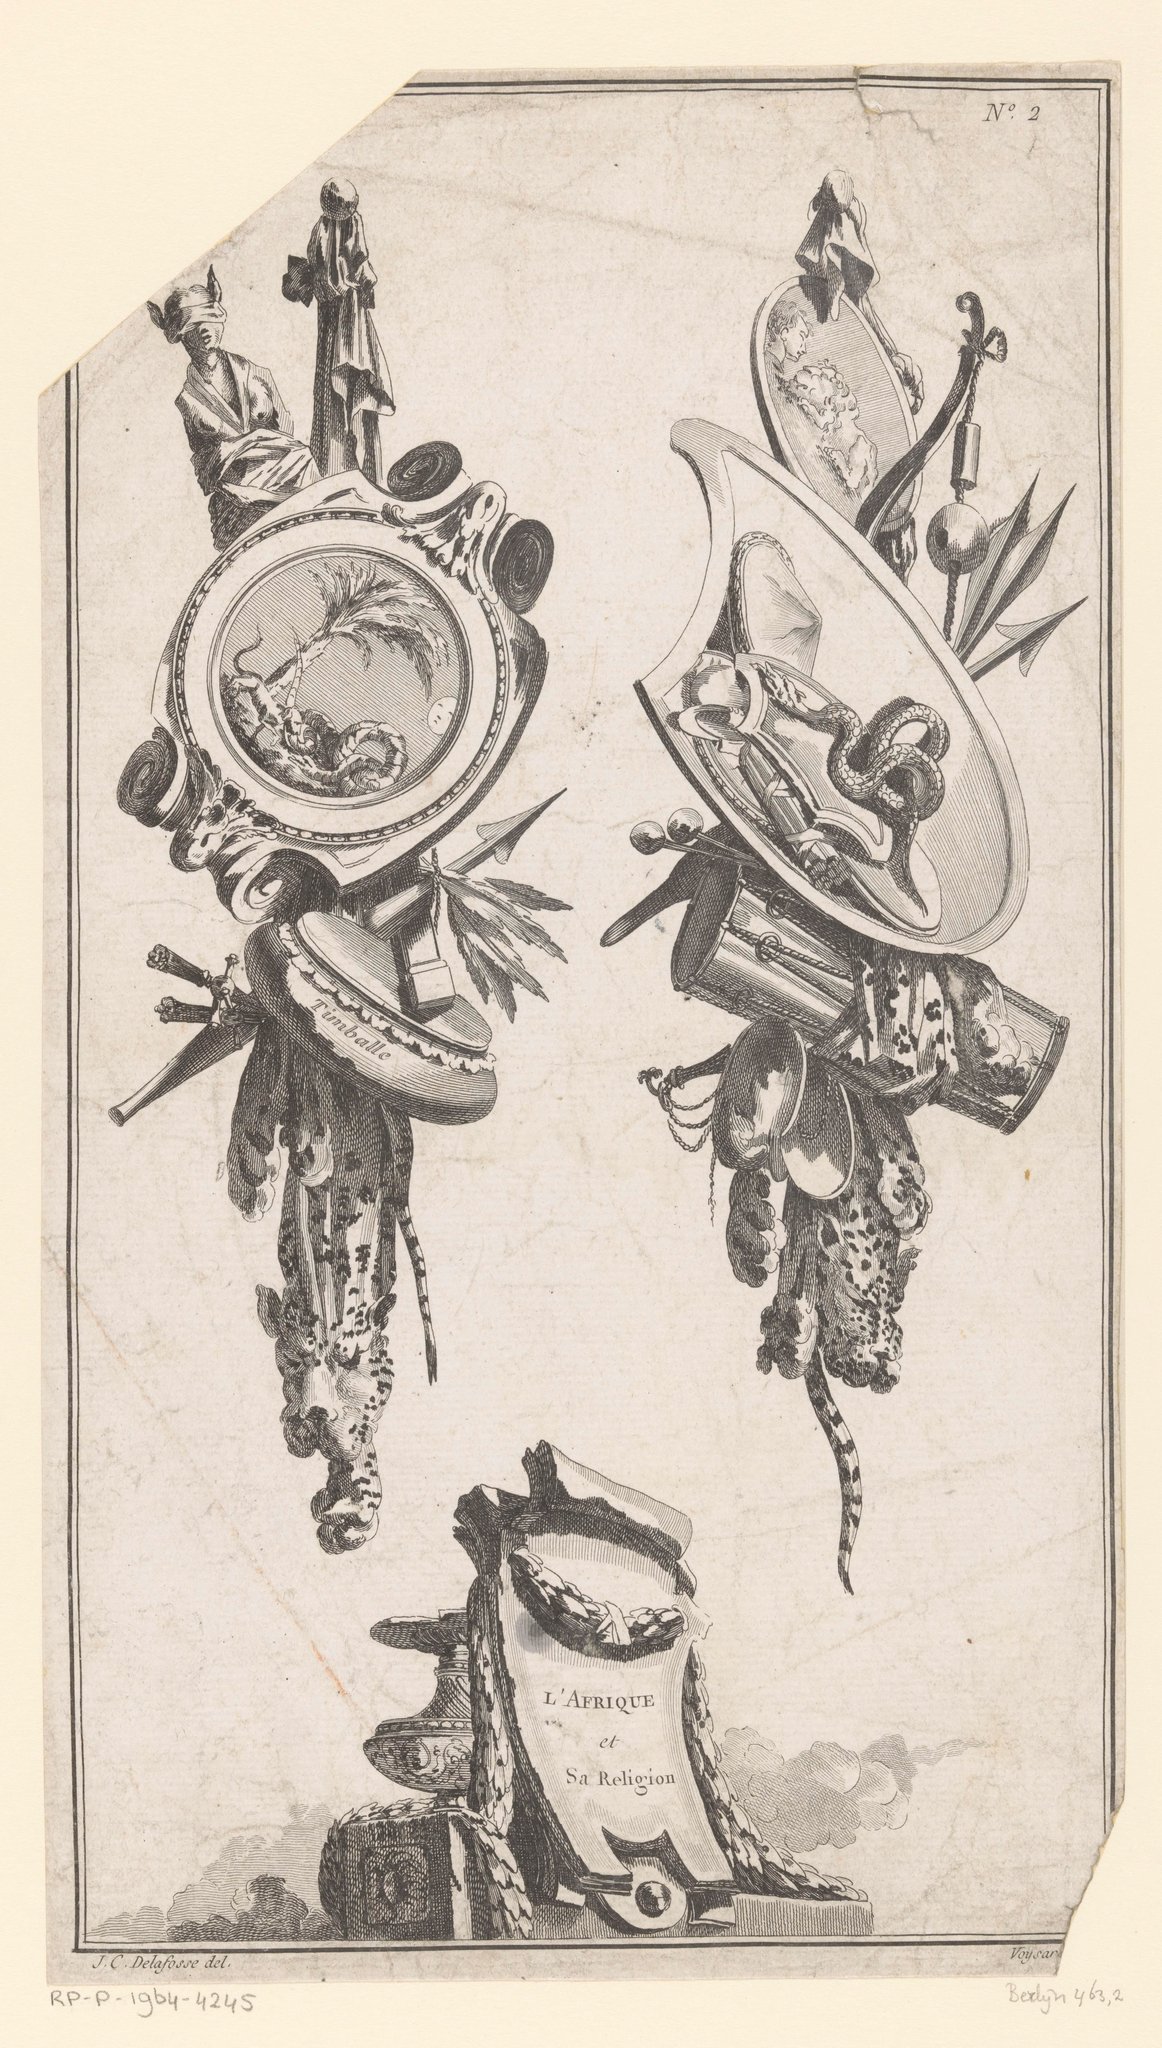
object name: ornament print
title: 2e Cahier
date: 1772-1779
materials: paper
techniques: engraving, etching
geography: paris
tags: trophy, i.e.: decorative arrangement of symbolic or typical objects ~ ornament, africa represented allegorically; 'africa' (ripa)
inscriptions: collector's mark: Lugt 2760, collector's mark: Lugt 2228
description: Twee trofeeën met schilden, wapens, Afrikaanse trommels en luipaardvellen.